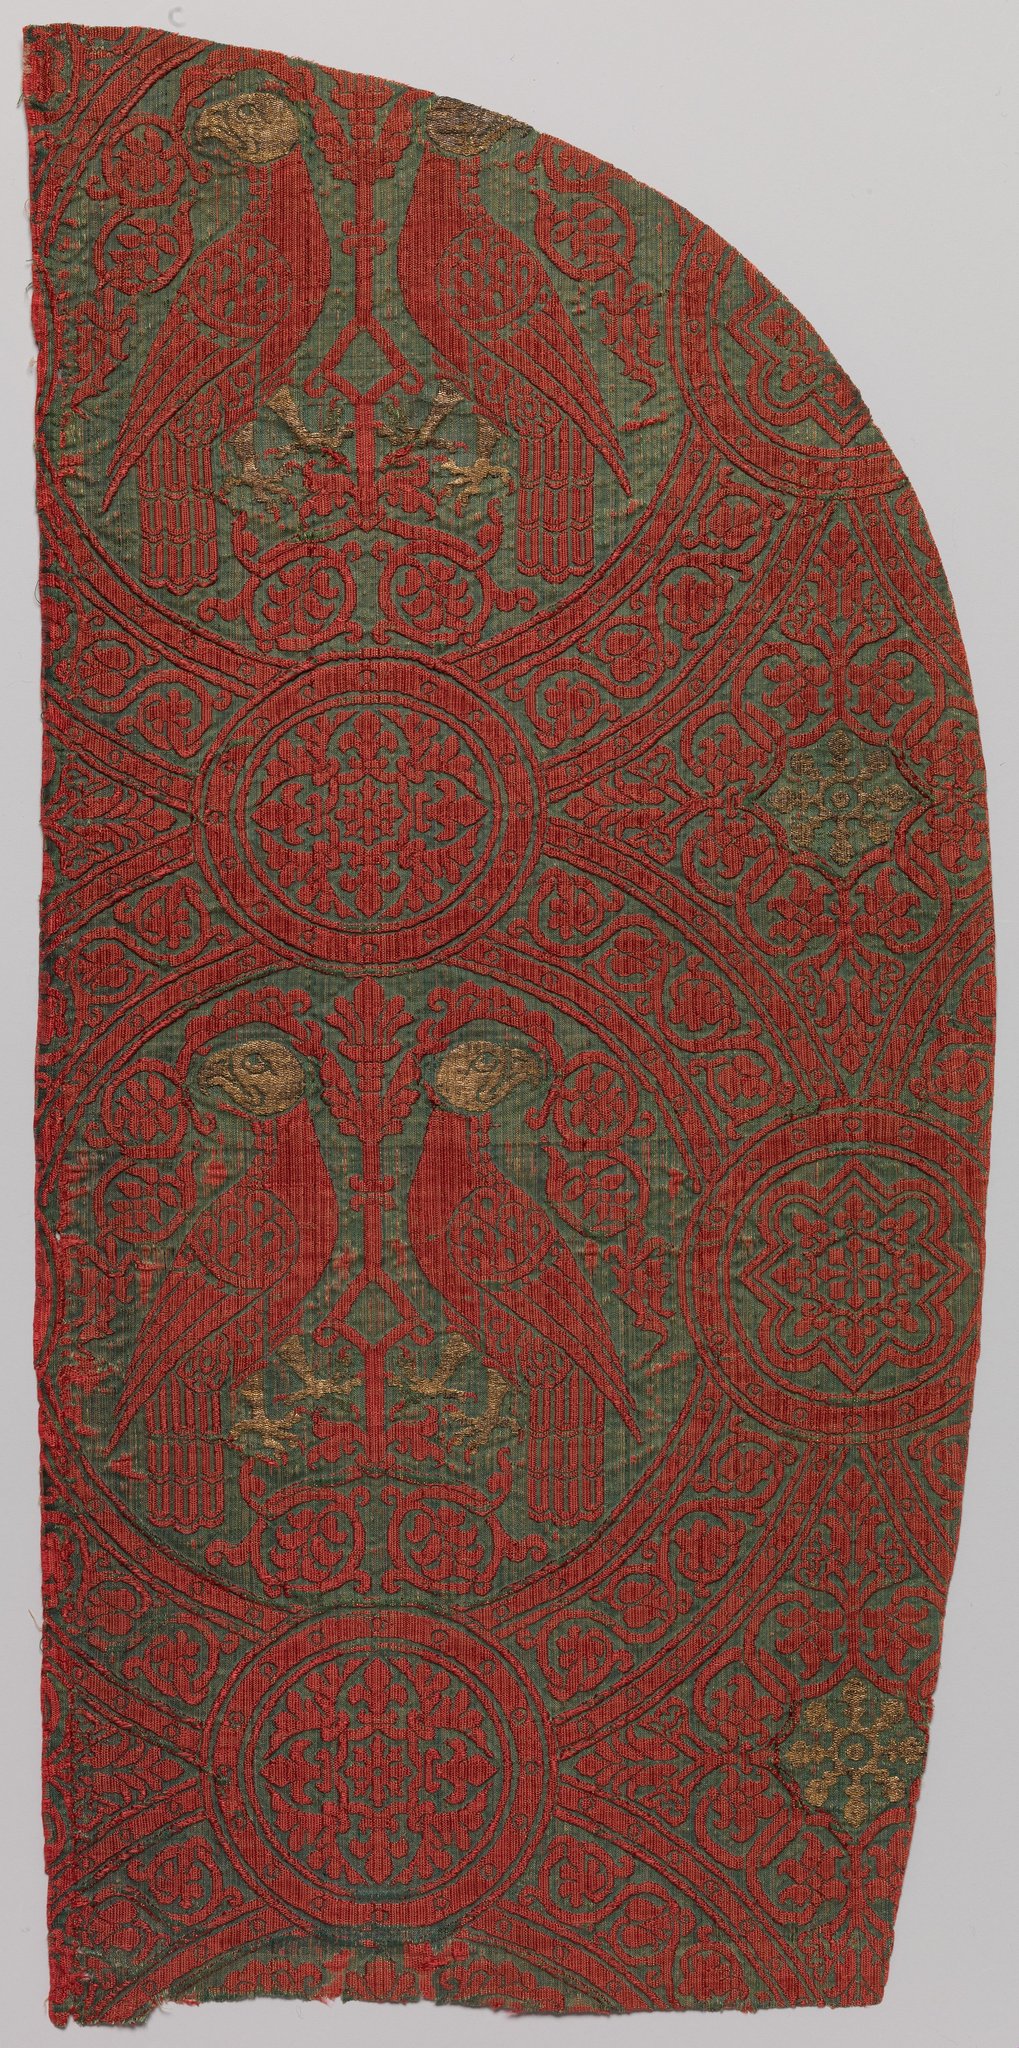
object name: textile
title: Woven Silk with Paired Parrots in Roundels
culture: sicilian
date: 1201-1300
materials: gilt, metal thread, silk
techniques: weave